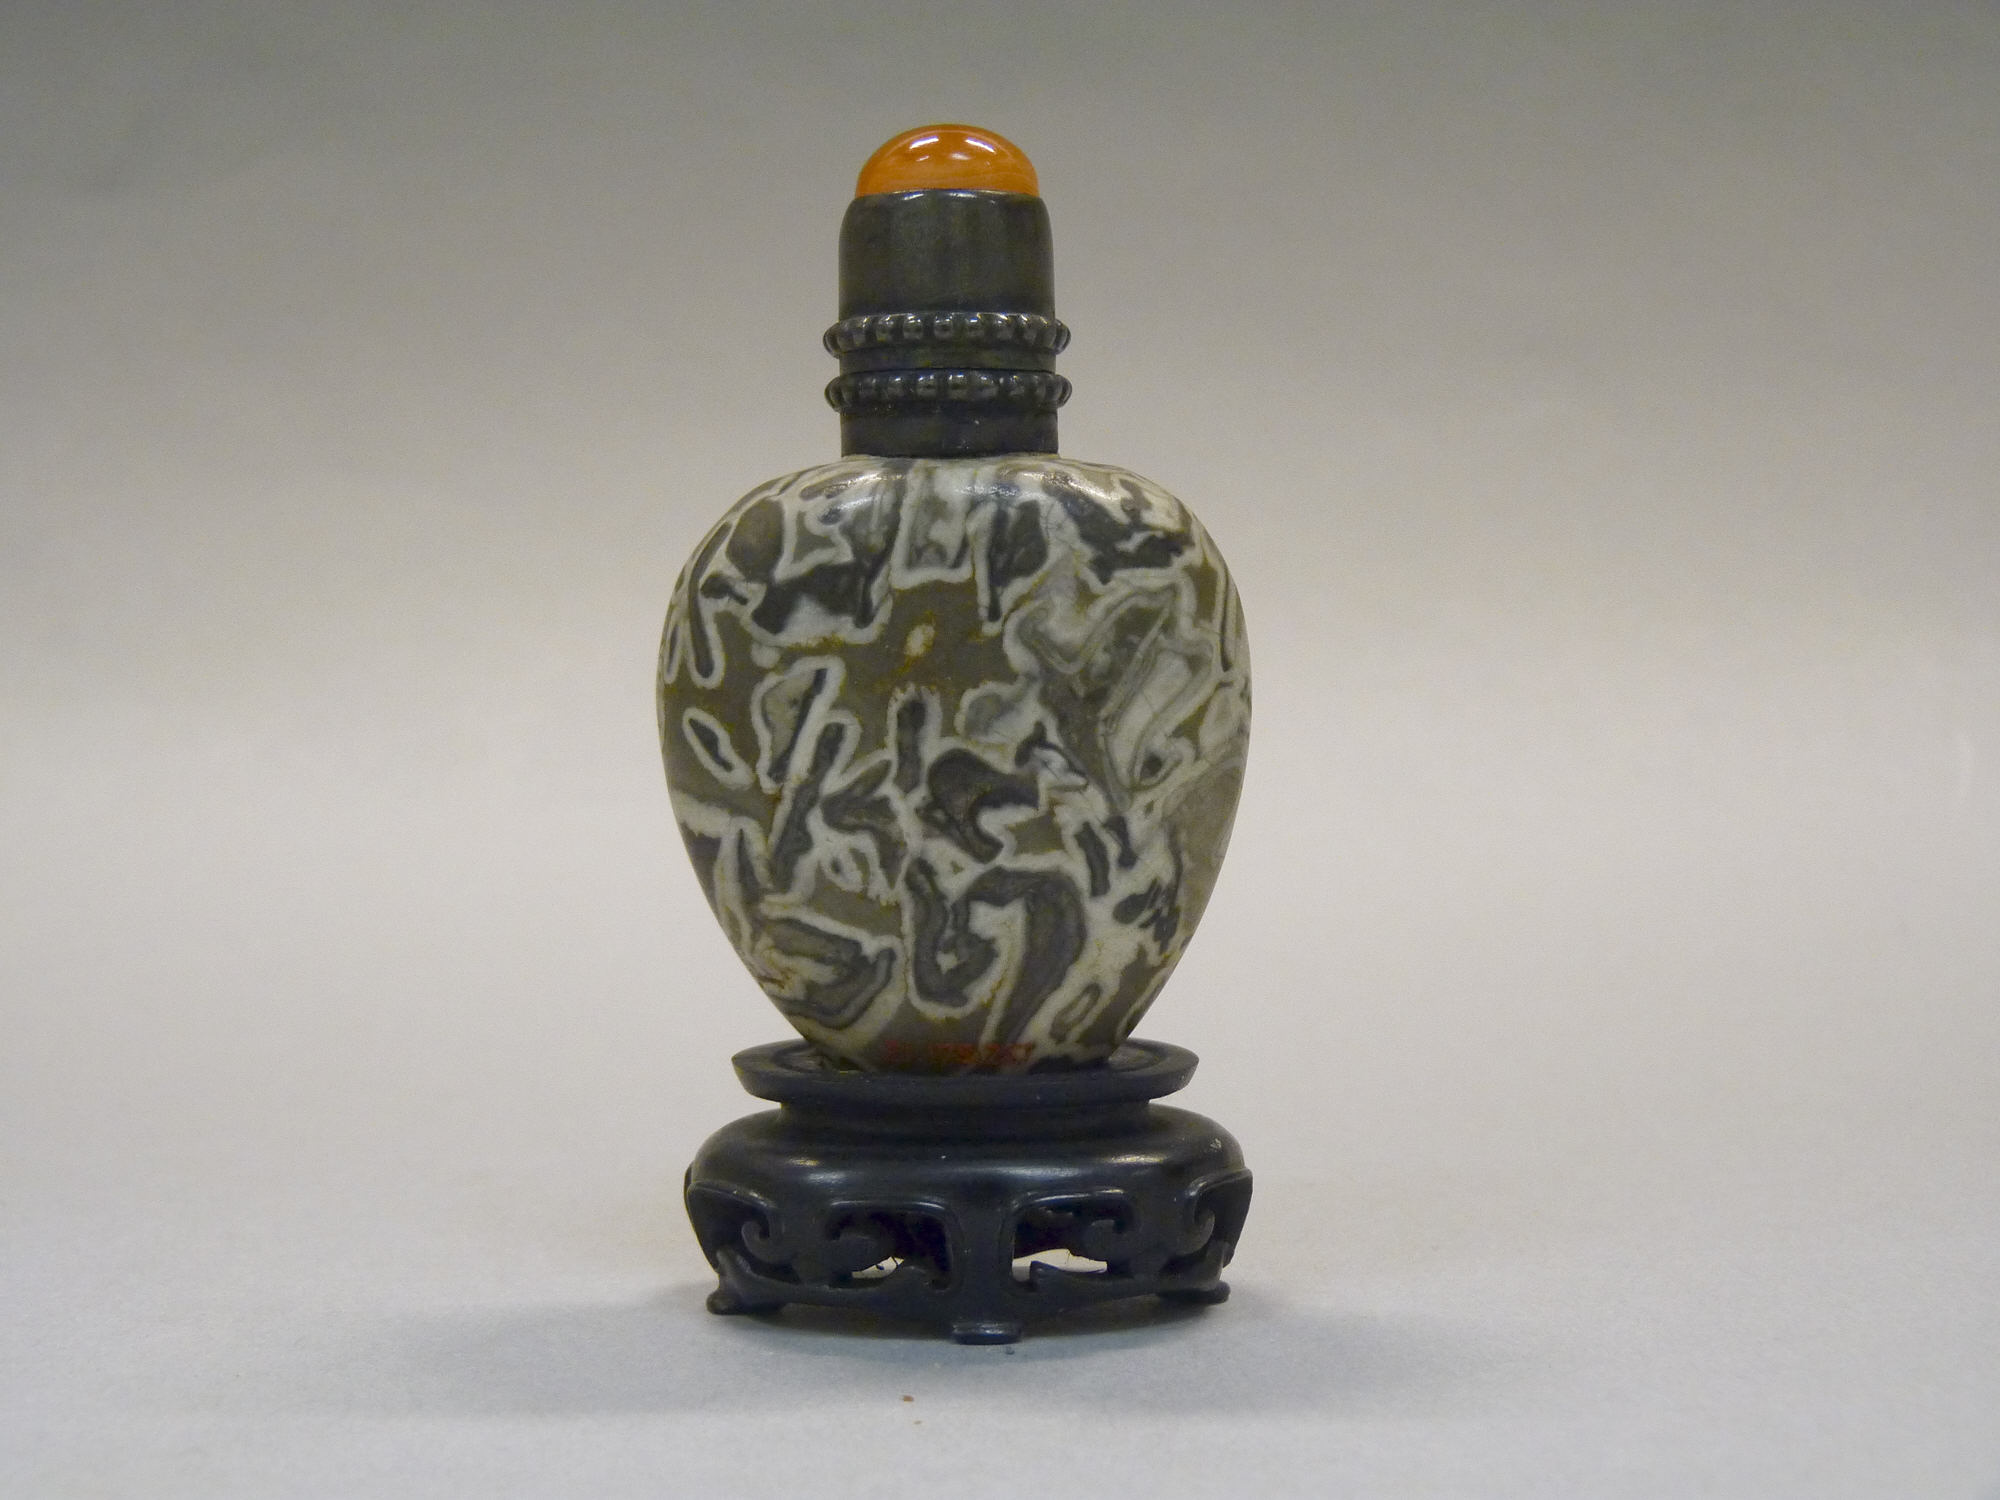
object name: snuff bottle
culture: chinese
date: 1801-1900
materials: stone